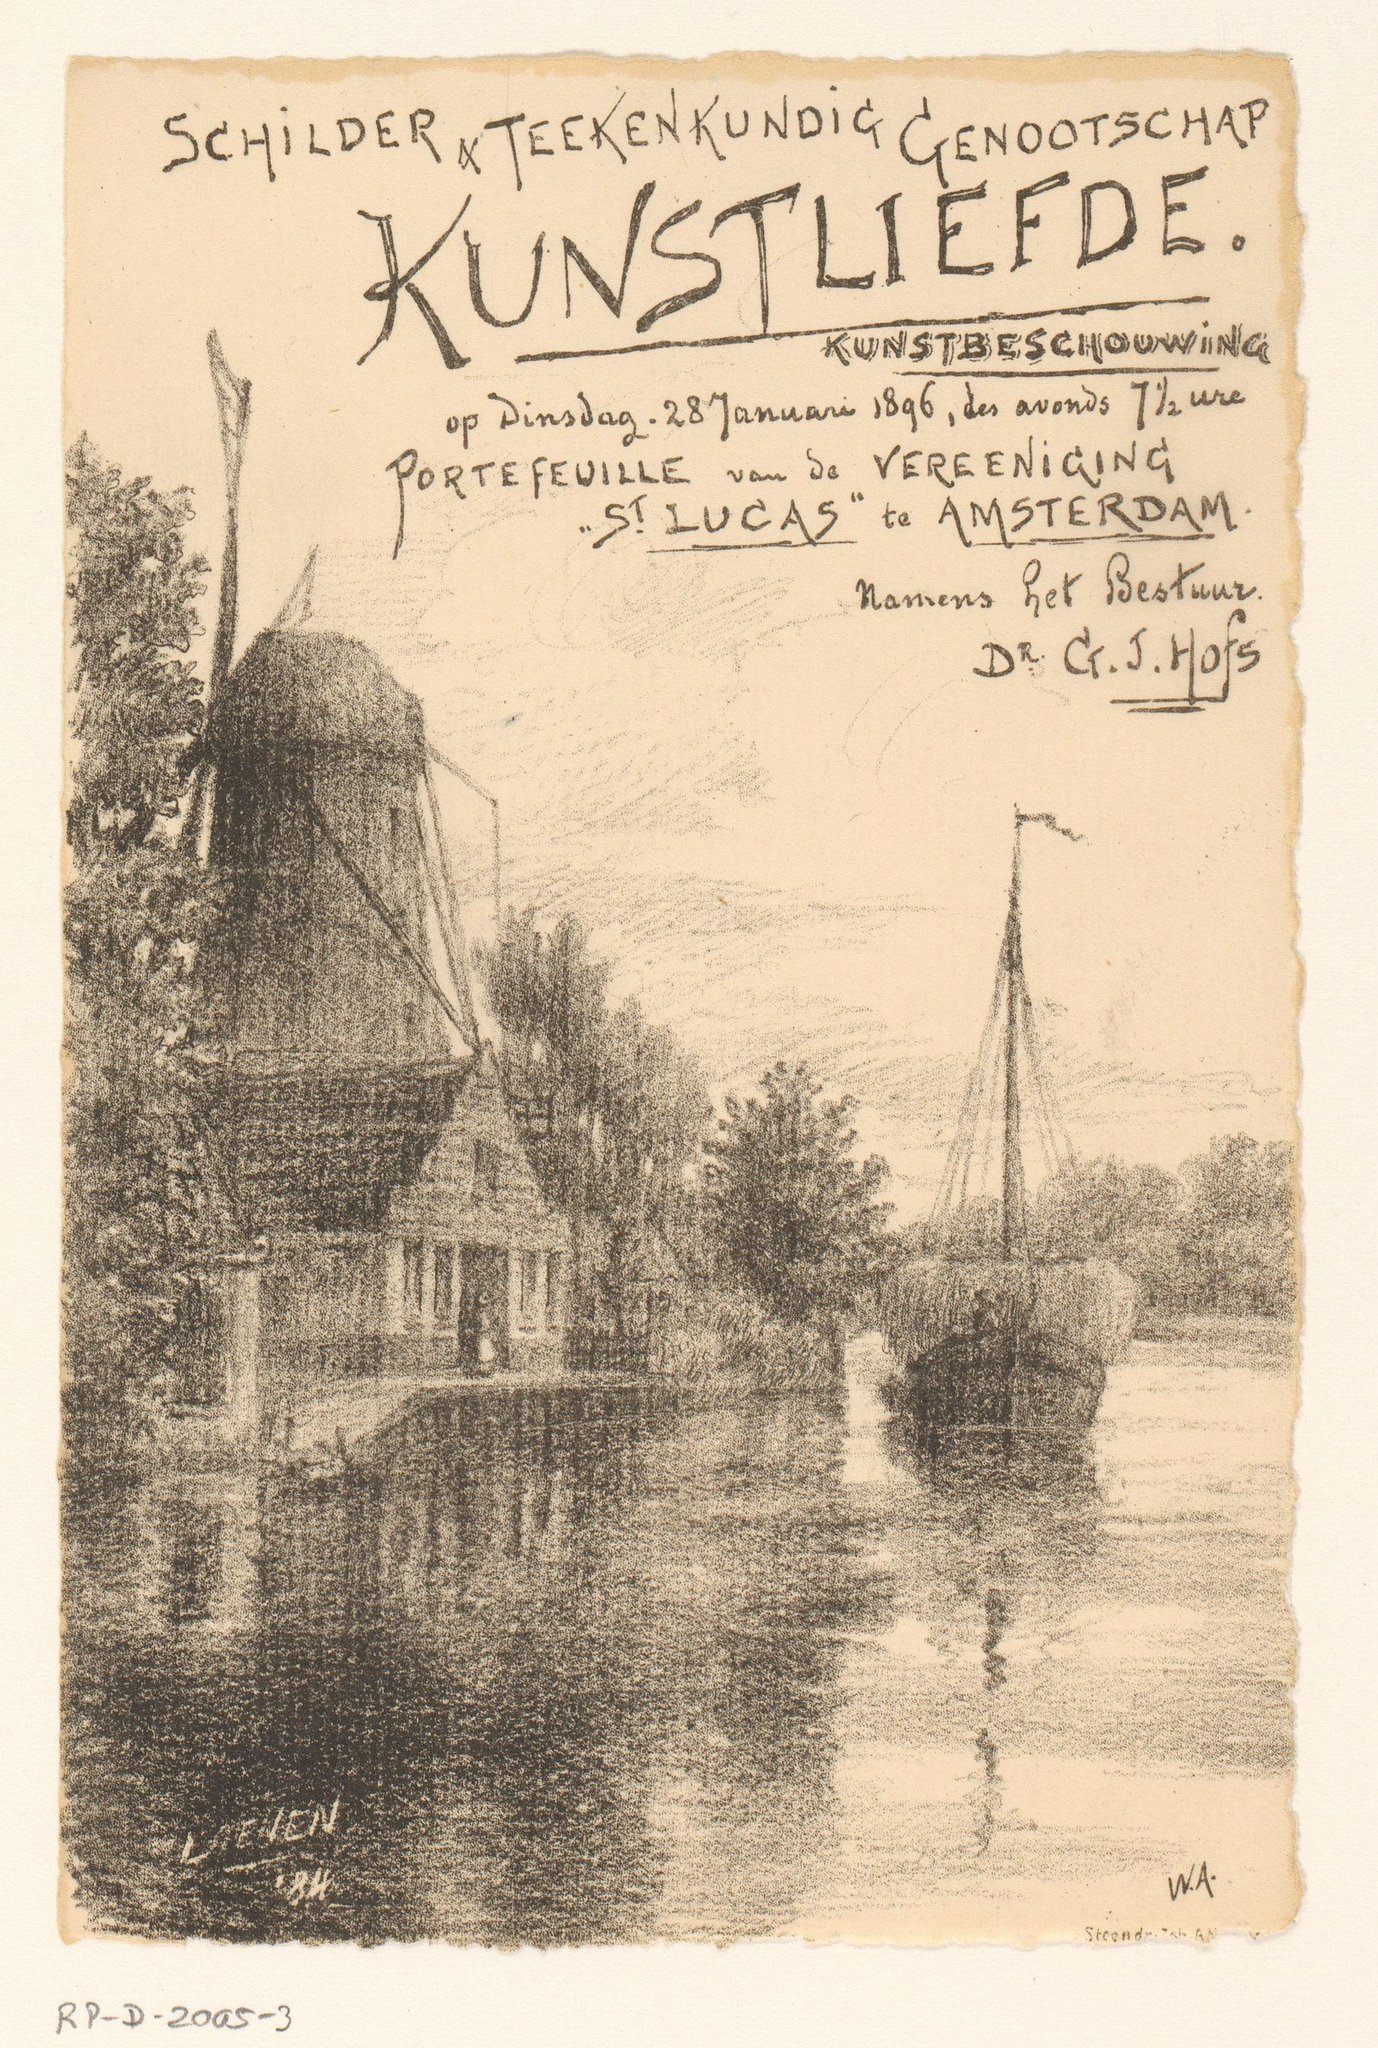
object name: invitation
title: Uitnodiging van Schilder- en Teekenkundig Genootschap "Kunstliefde" voor een kunstbeschouwing, 28 januari 1896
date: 1801-1896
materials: paper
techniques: lithograph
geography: utrecht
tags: criticizing and discussing art, art criticism, circle, club of artists, collecting and exhibiting products of the fine arts, canals, waters (in village), windmill in landscape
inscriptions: collector's mark: Lugt 2228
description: Schuit op het water nabij een molen. Uitnodiging van Schilder- en Teekenkundig Genootschap "Kunstliefde" voor een kunstbeschouwing op 28 januari 1896 van de portefeuille van de Vereeniging "St. Lucas" te Amsterdam.